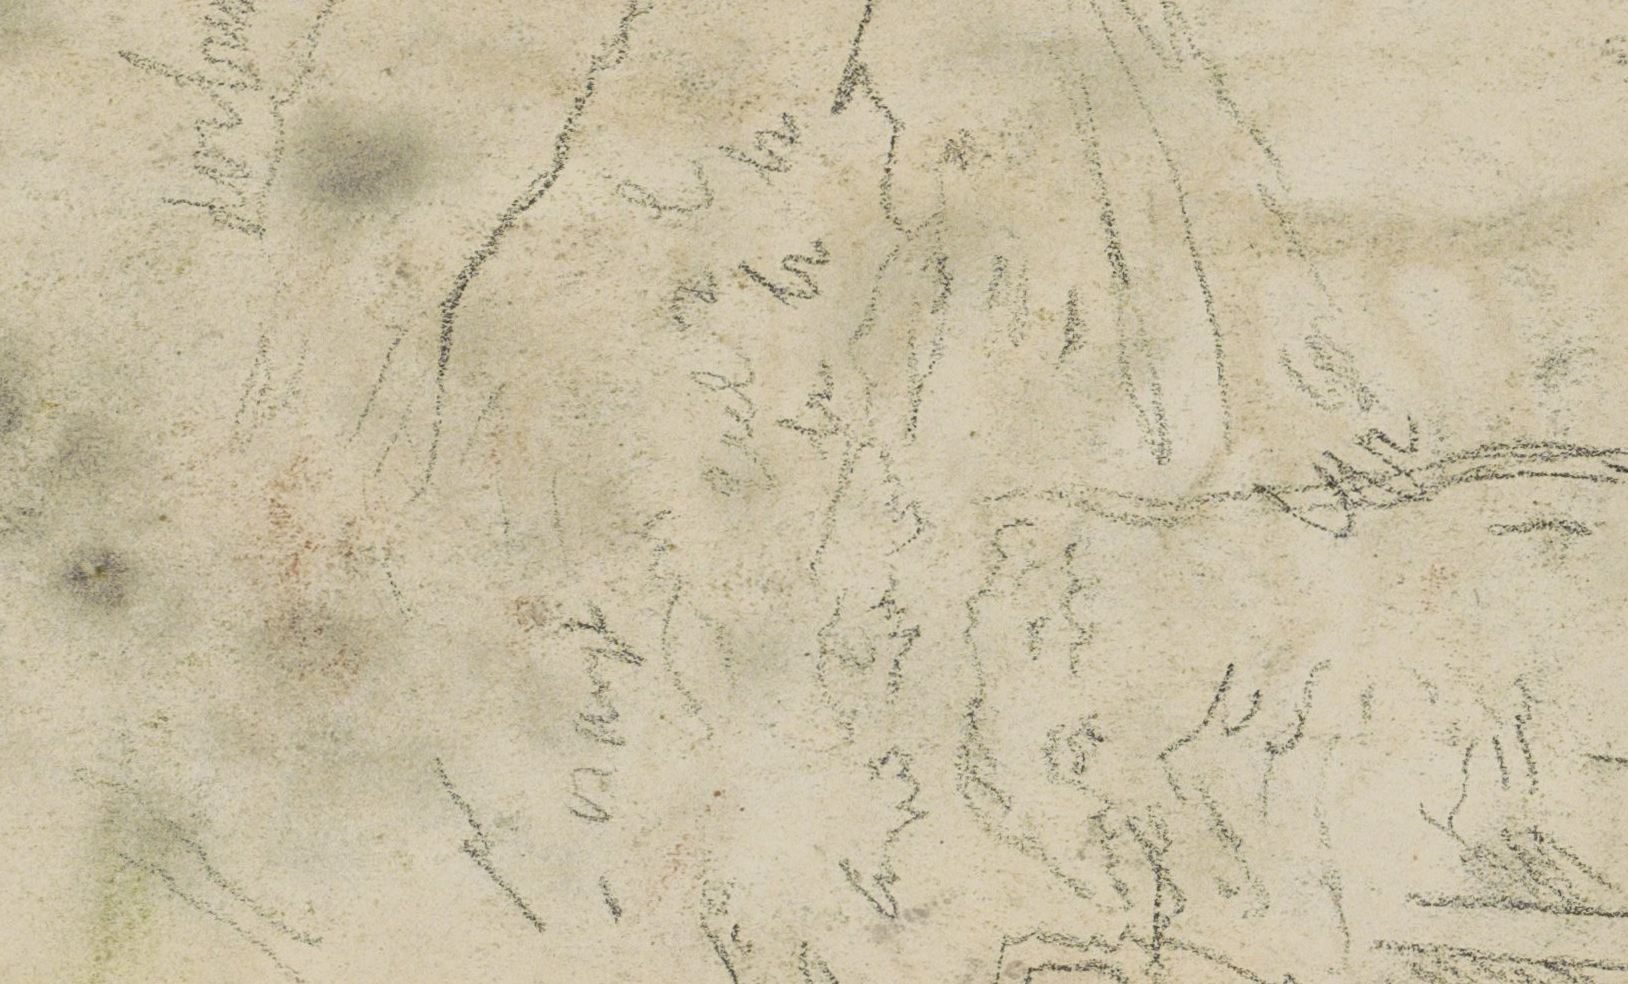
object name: sketchbook leaf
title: Landschap met een heuvel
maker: johan antonie de jonge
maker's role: draughtsman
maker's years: 1864-1927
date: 1881-1927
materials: chalk, paper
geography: south holland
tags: low hill country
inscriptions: kleurnotitie, handgeschreven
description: Landschap met een heuvel. Blad 2 verso uit een schetsboek met 34 bladen.